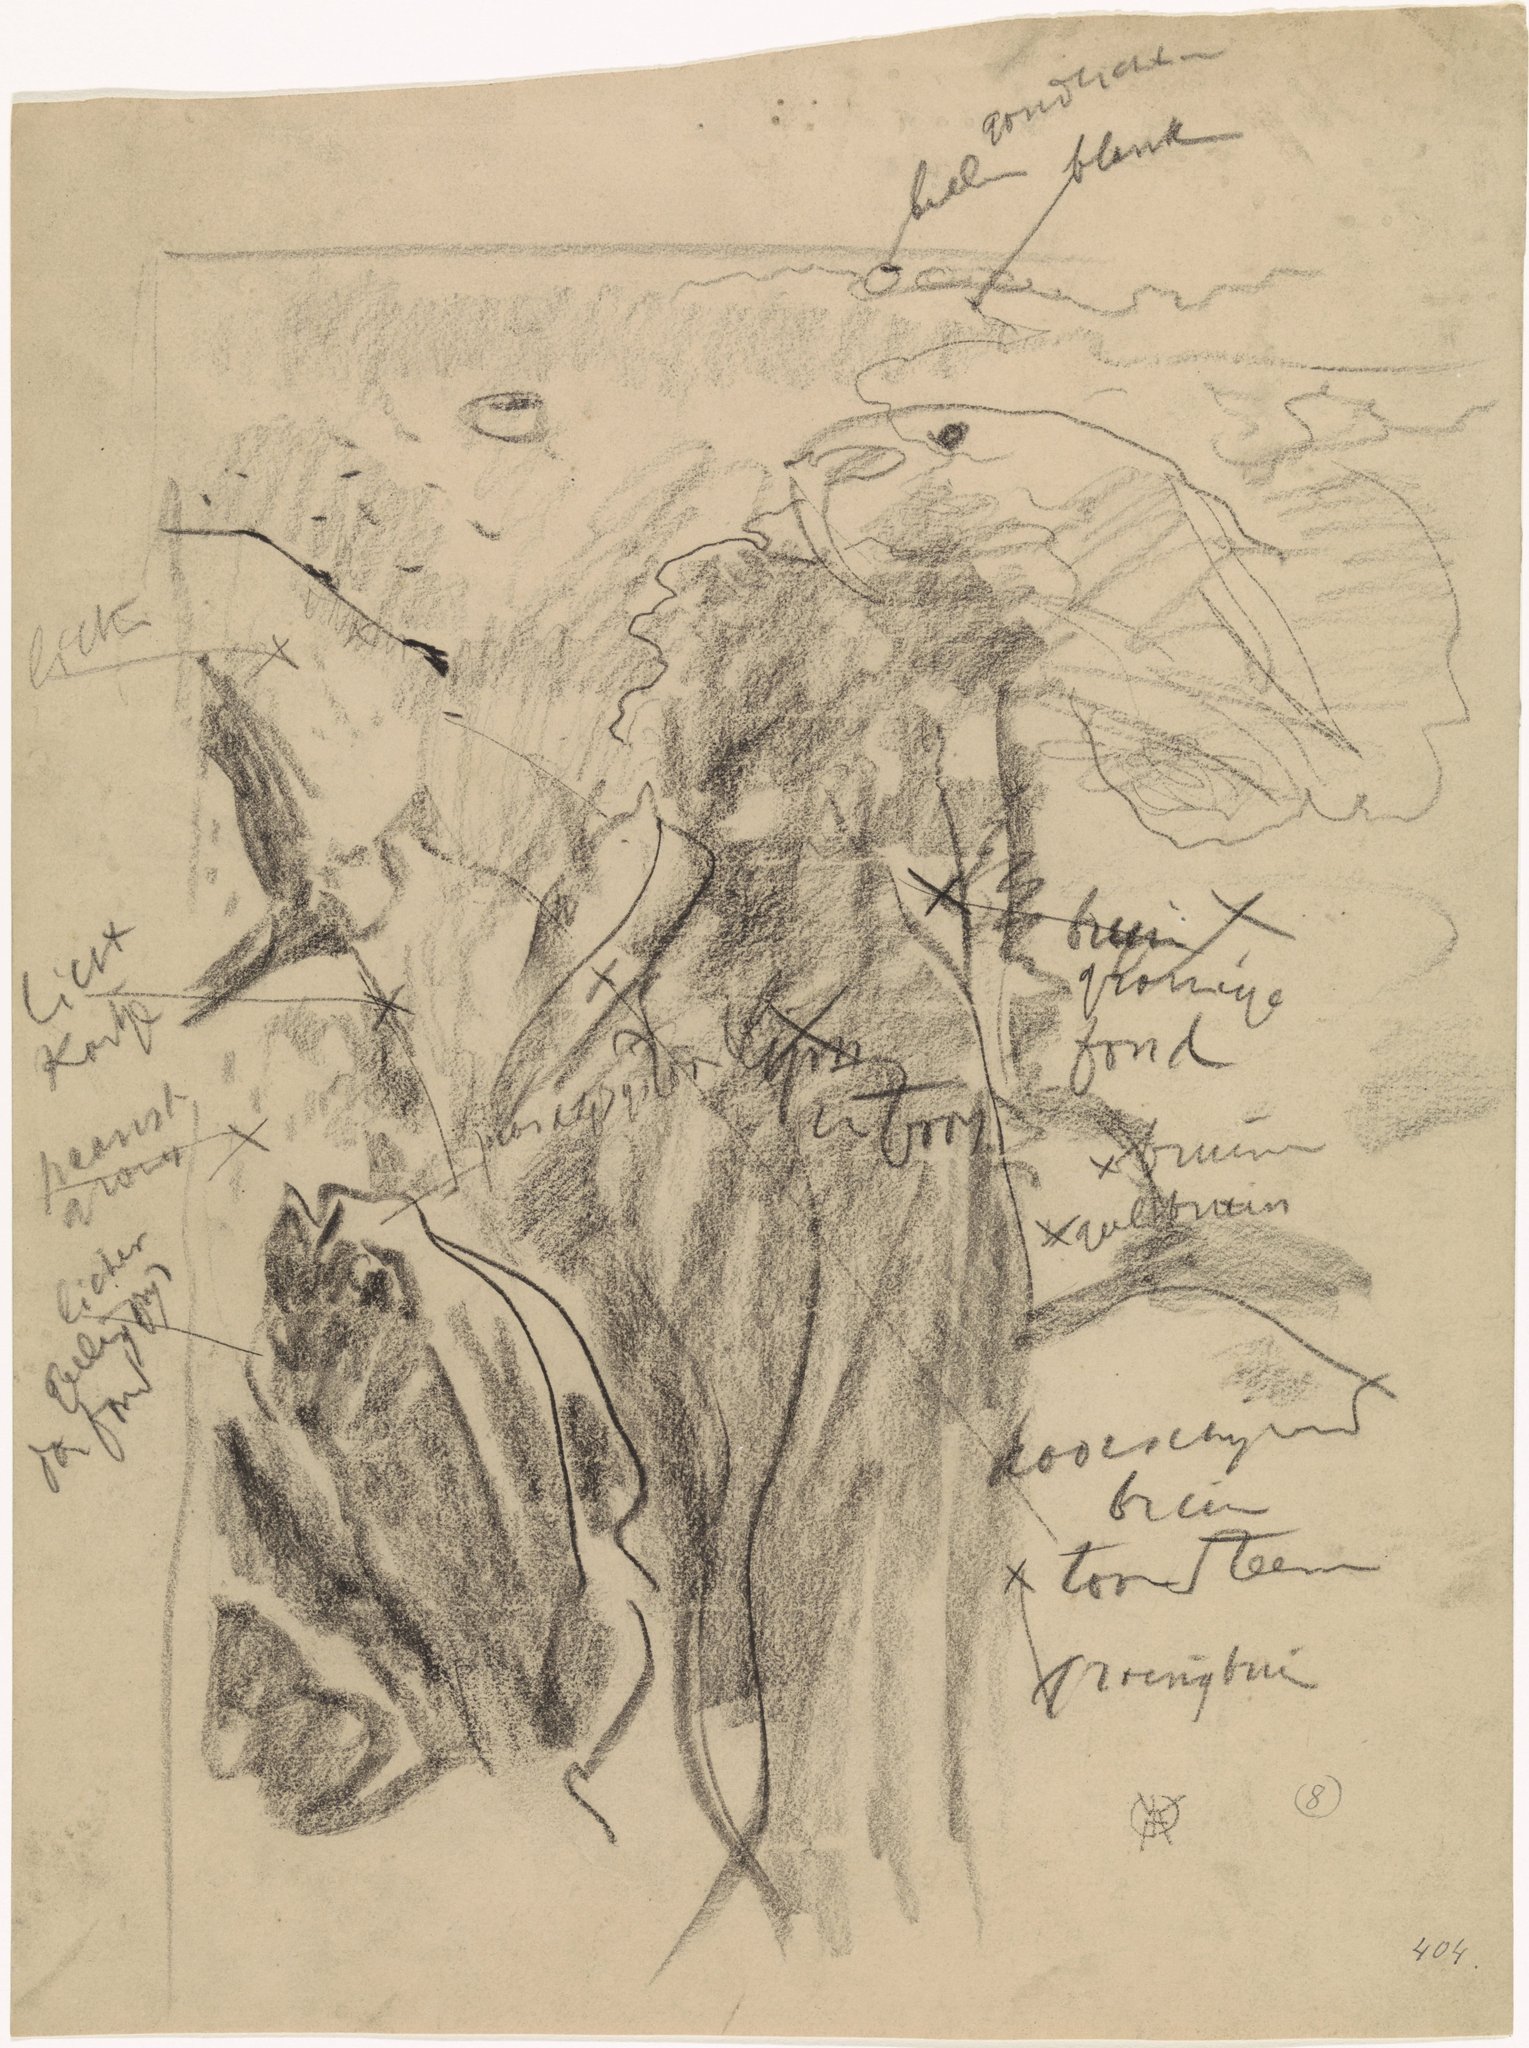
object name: drawing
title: Schets van een aquarium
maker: gerrit willem dijsselhof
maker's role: designer, draughtsman, print maker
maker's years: 1866-1924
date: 1876-1924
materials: chalk, paper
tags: aquarium